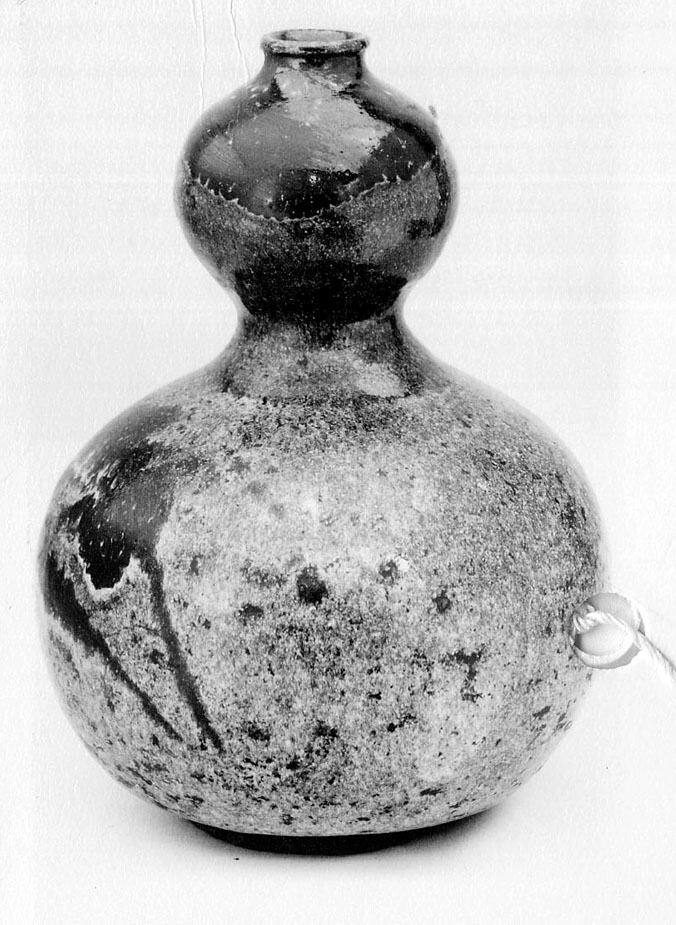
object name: bottle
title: Gourd-Shaped Bottle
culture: japanese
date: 1801-1900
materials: clay, glaze